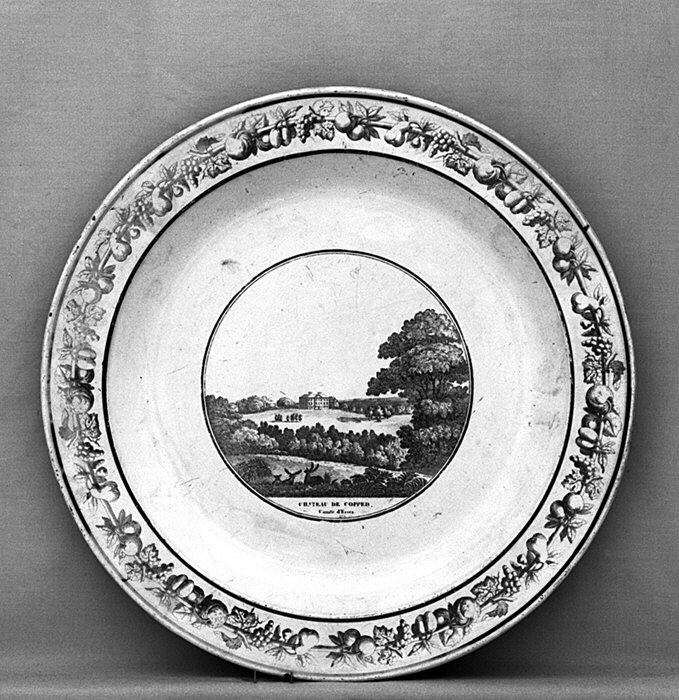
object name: plate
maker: stone, coquerel et legros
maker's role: maker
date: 1801-1833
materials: faience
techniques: glazing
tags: fruit,flowers,trees